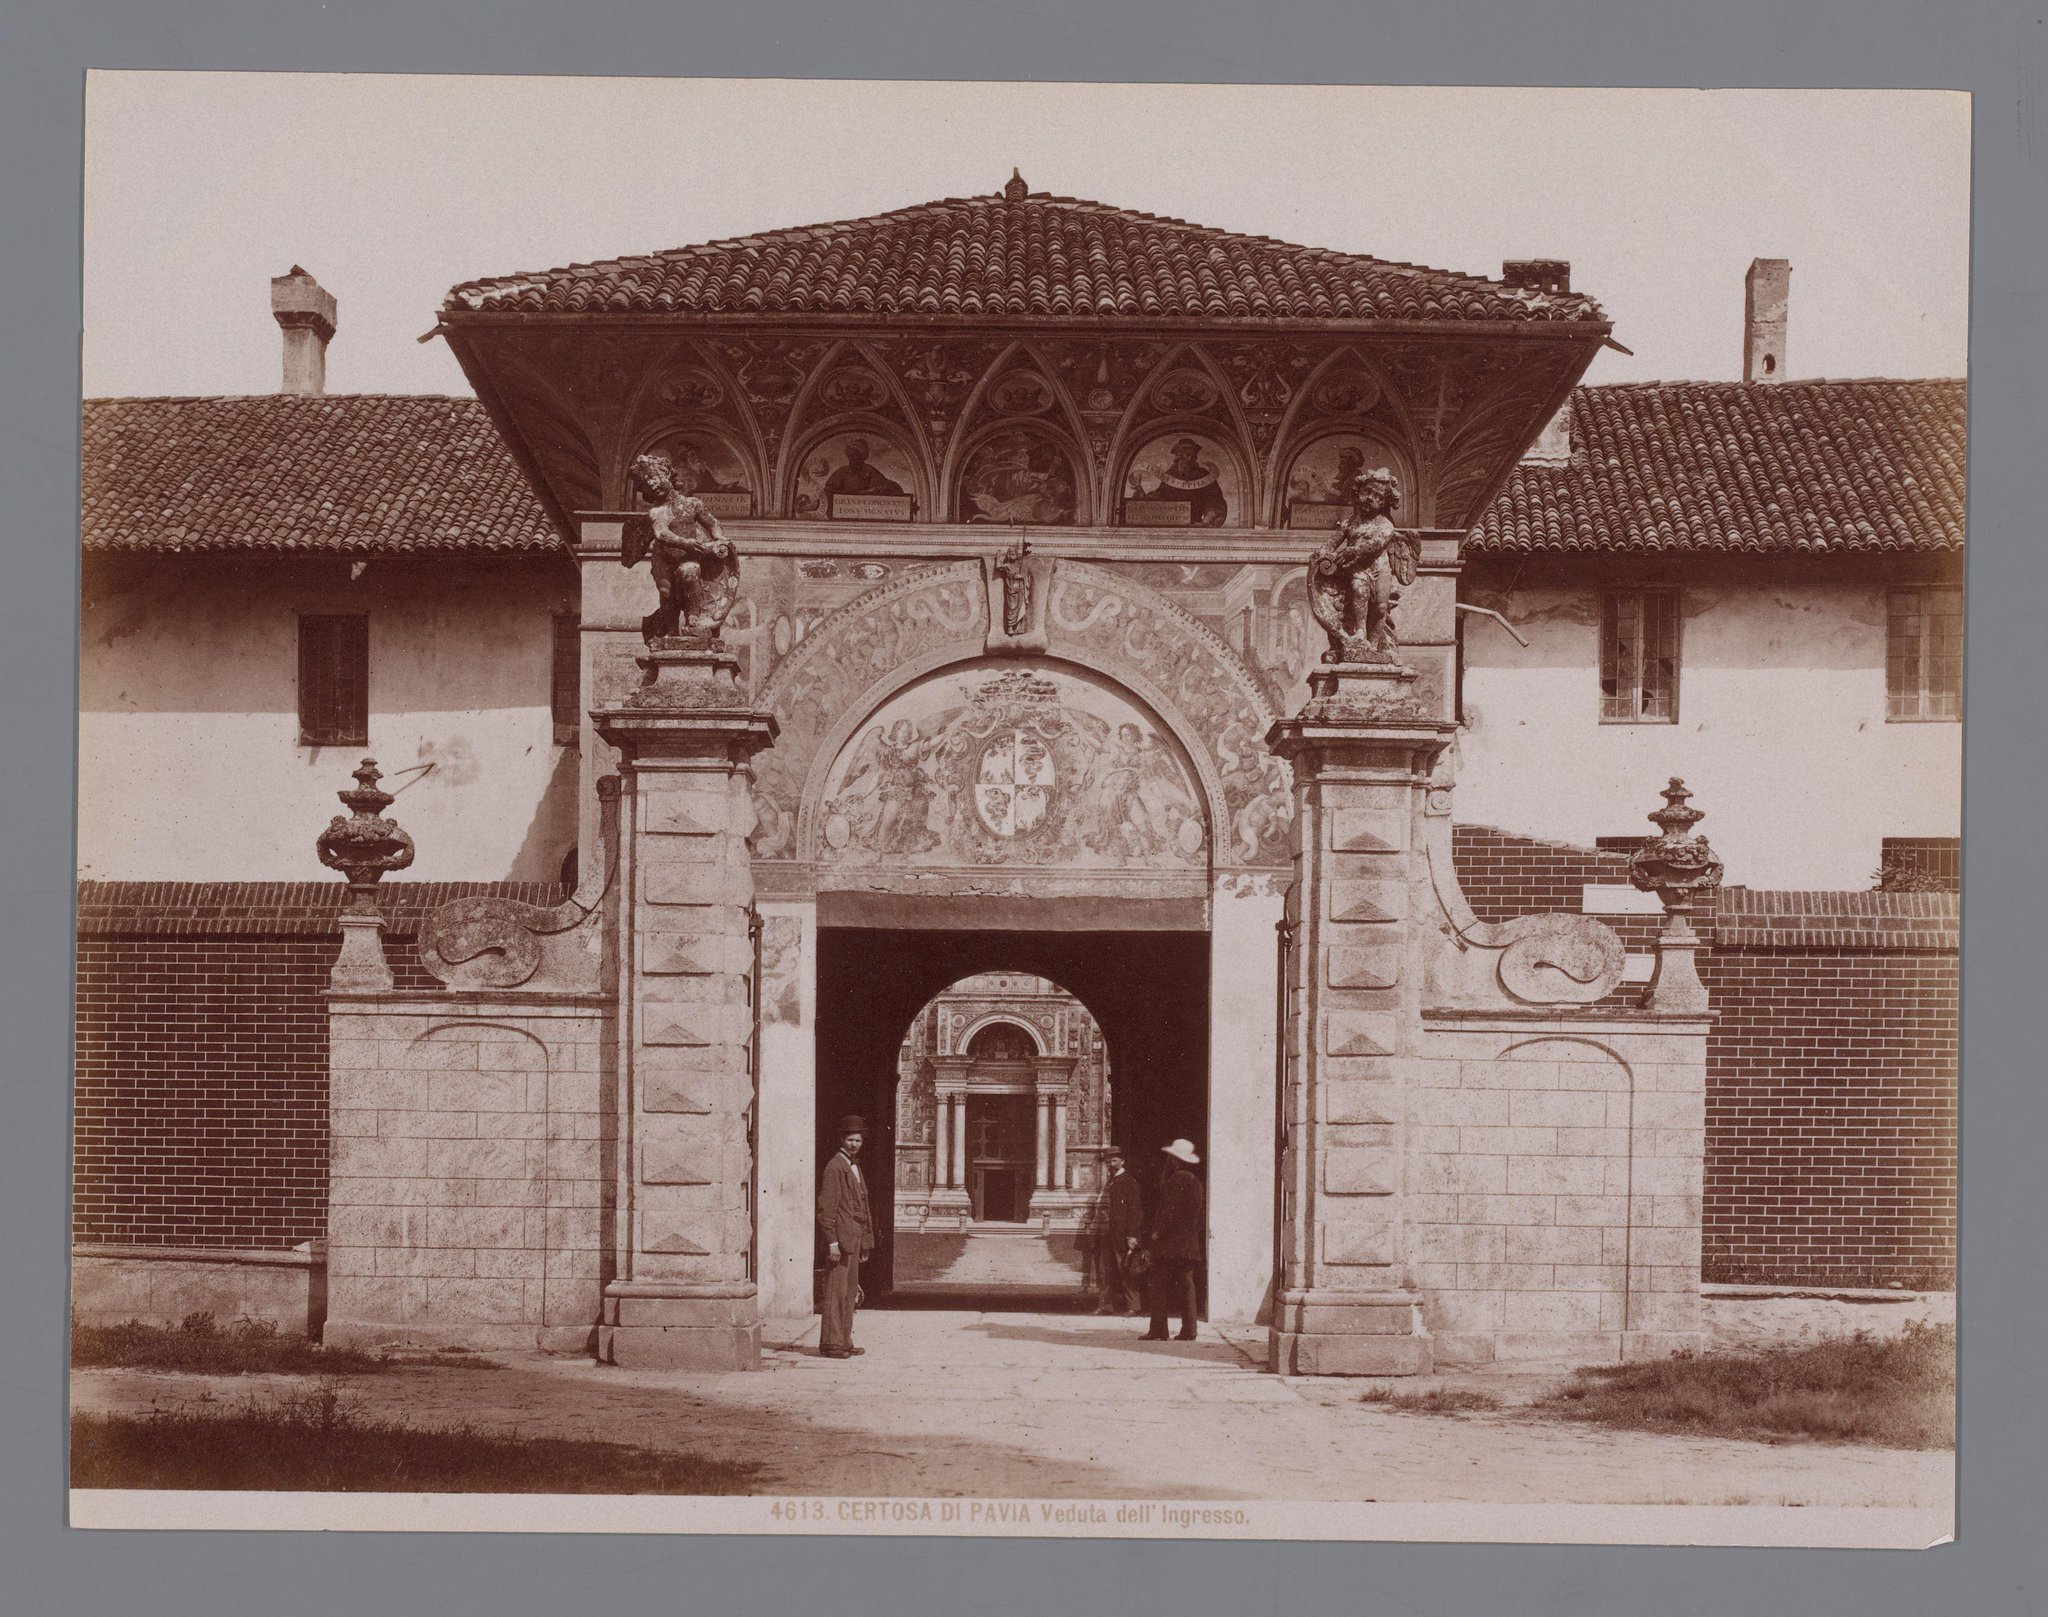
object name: photograph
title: Toegangspoort van de kloosterkerk Certosa di Pavia te Pavia, Italië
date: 1856-1881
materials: cardboard, paper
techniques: albumen print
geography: pavia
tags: gate, entrance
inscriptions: inscription: ‘Brogi (t)’, number: ‘4613.’, number: ‘13’